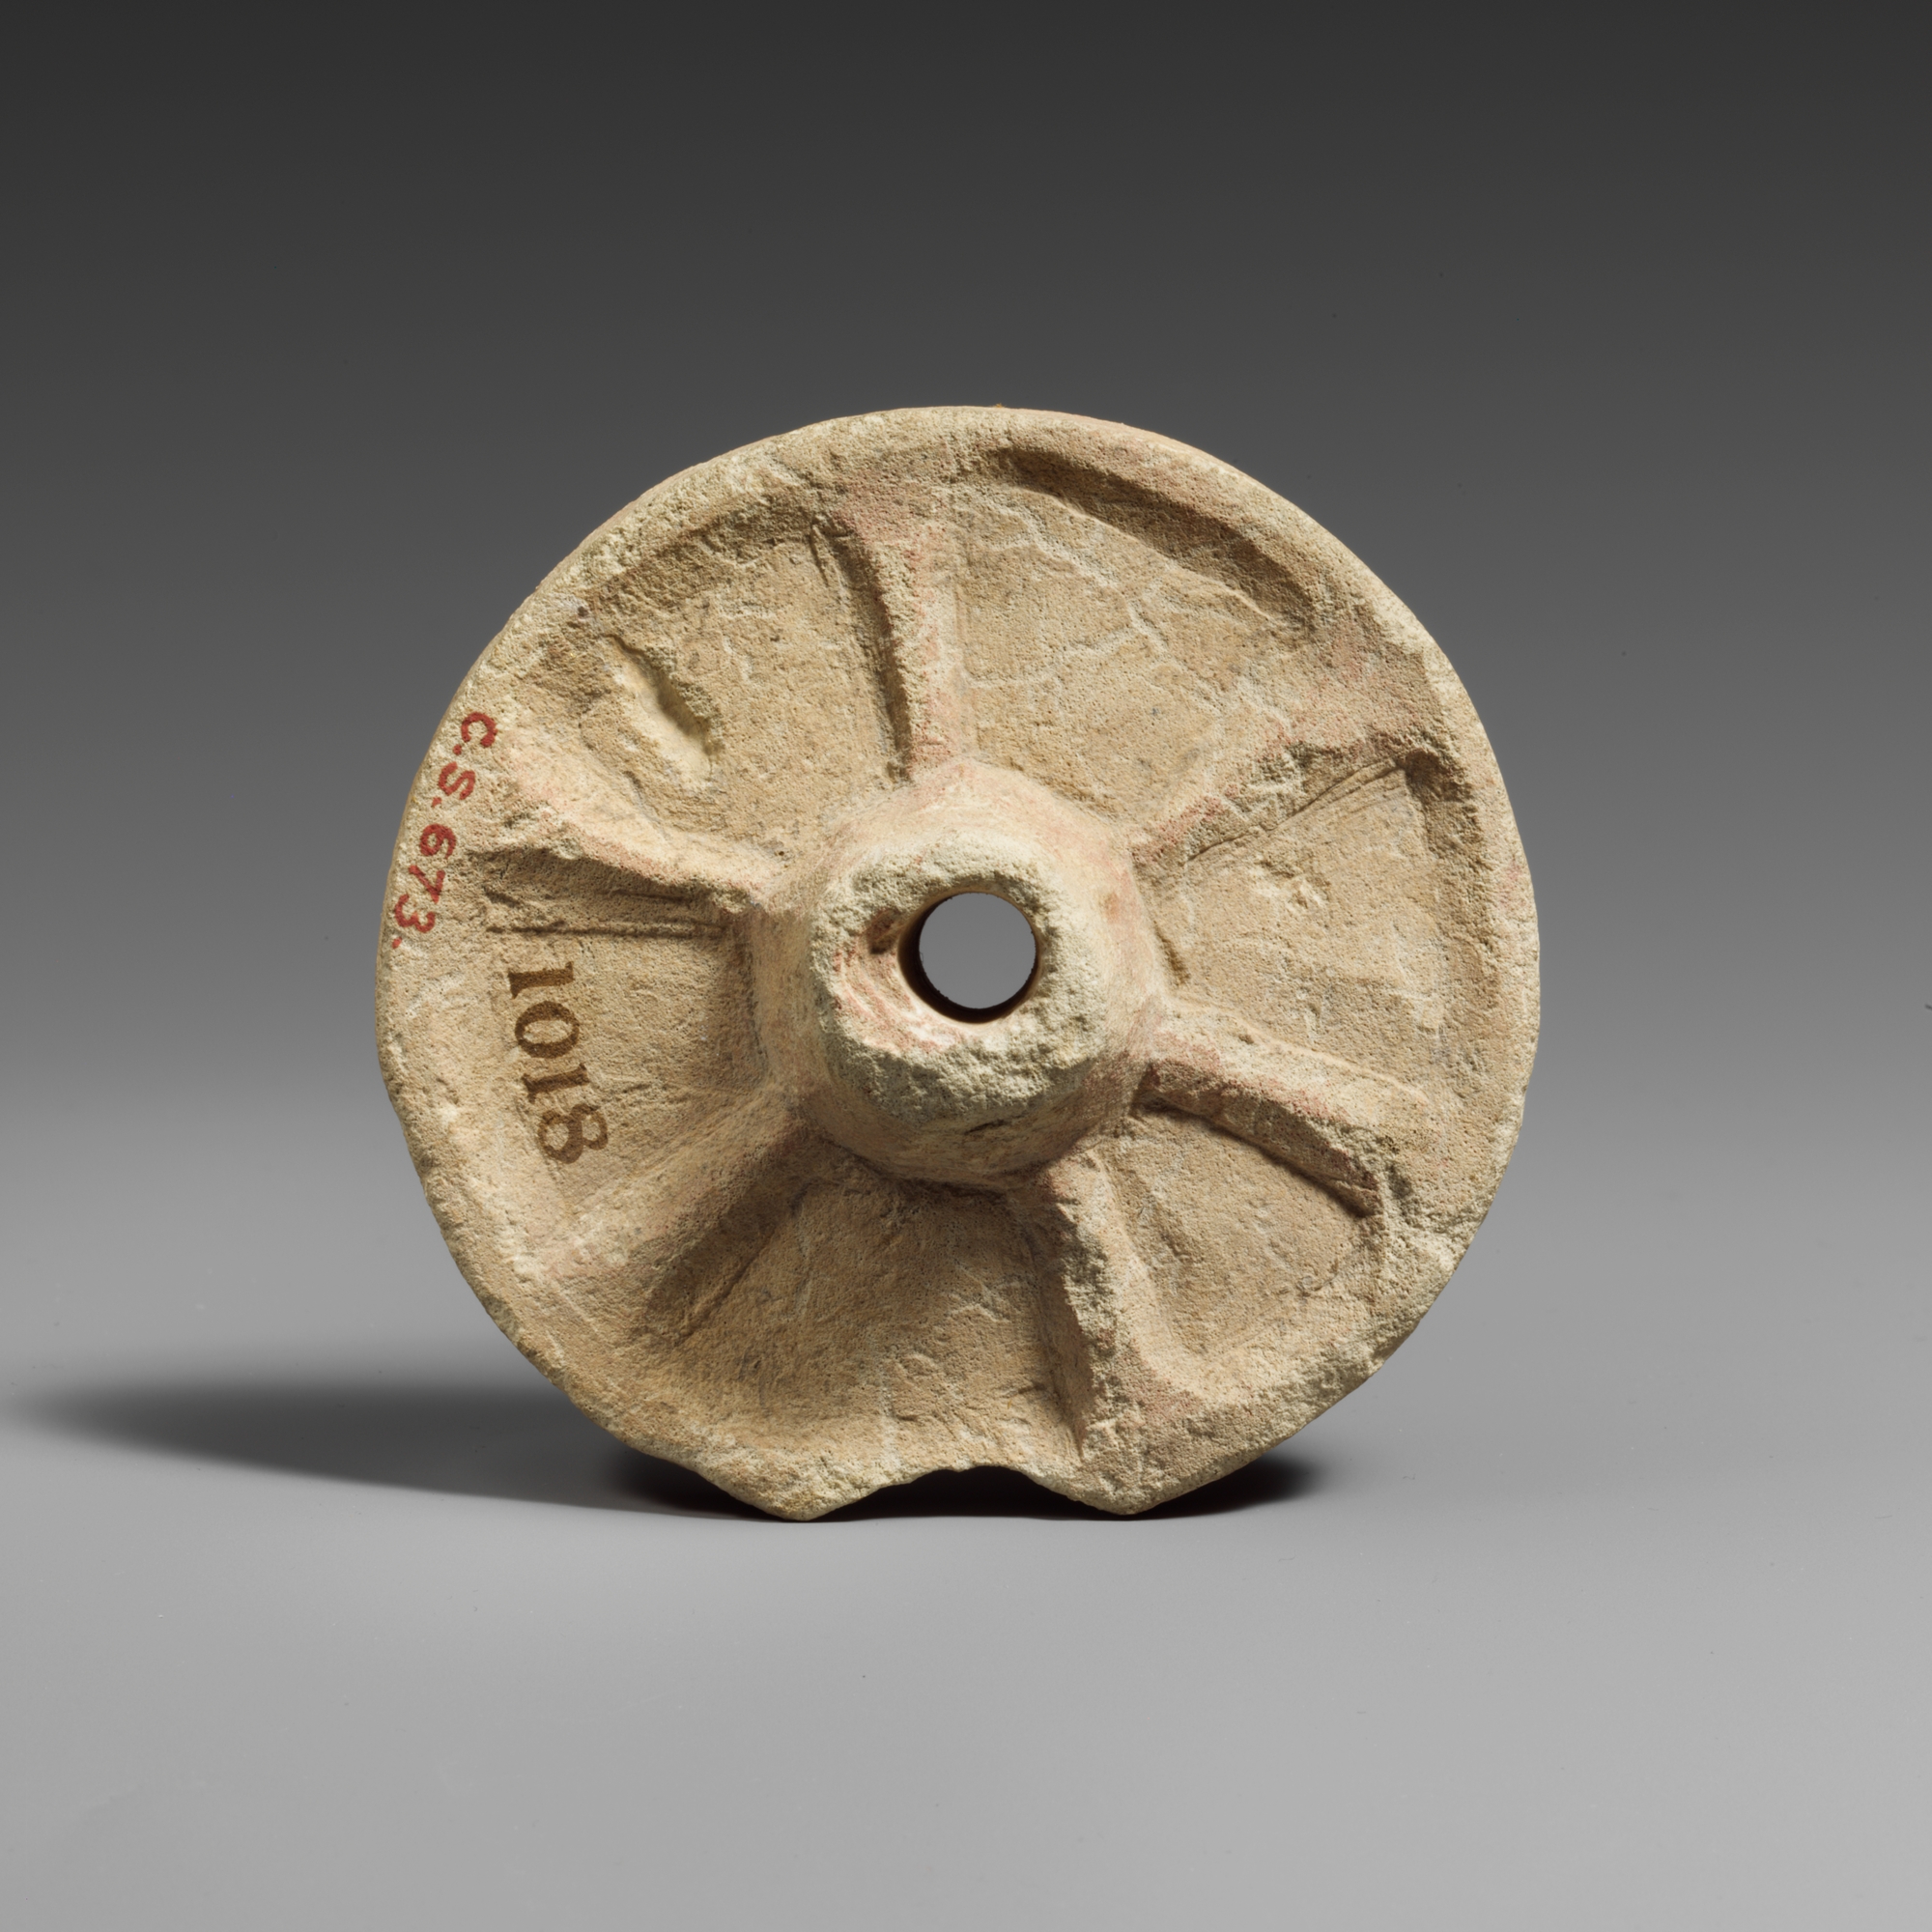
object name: chariot wheel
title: Limestone chariot wheel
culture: cypriot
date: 500-401 BCE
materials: limestone